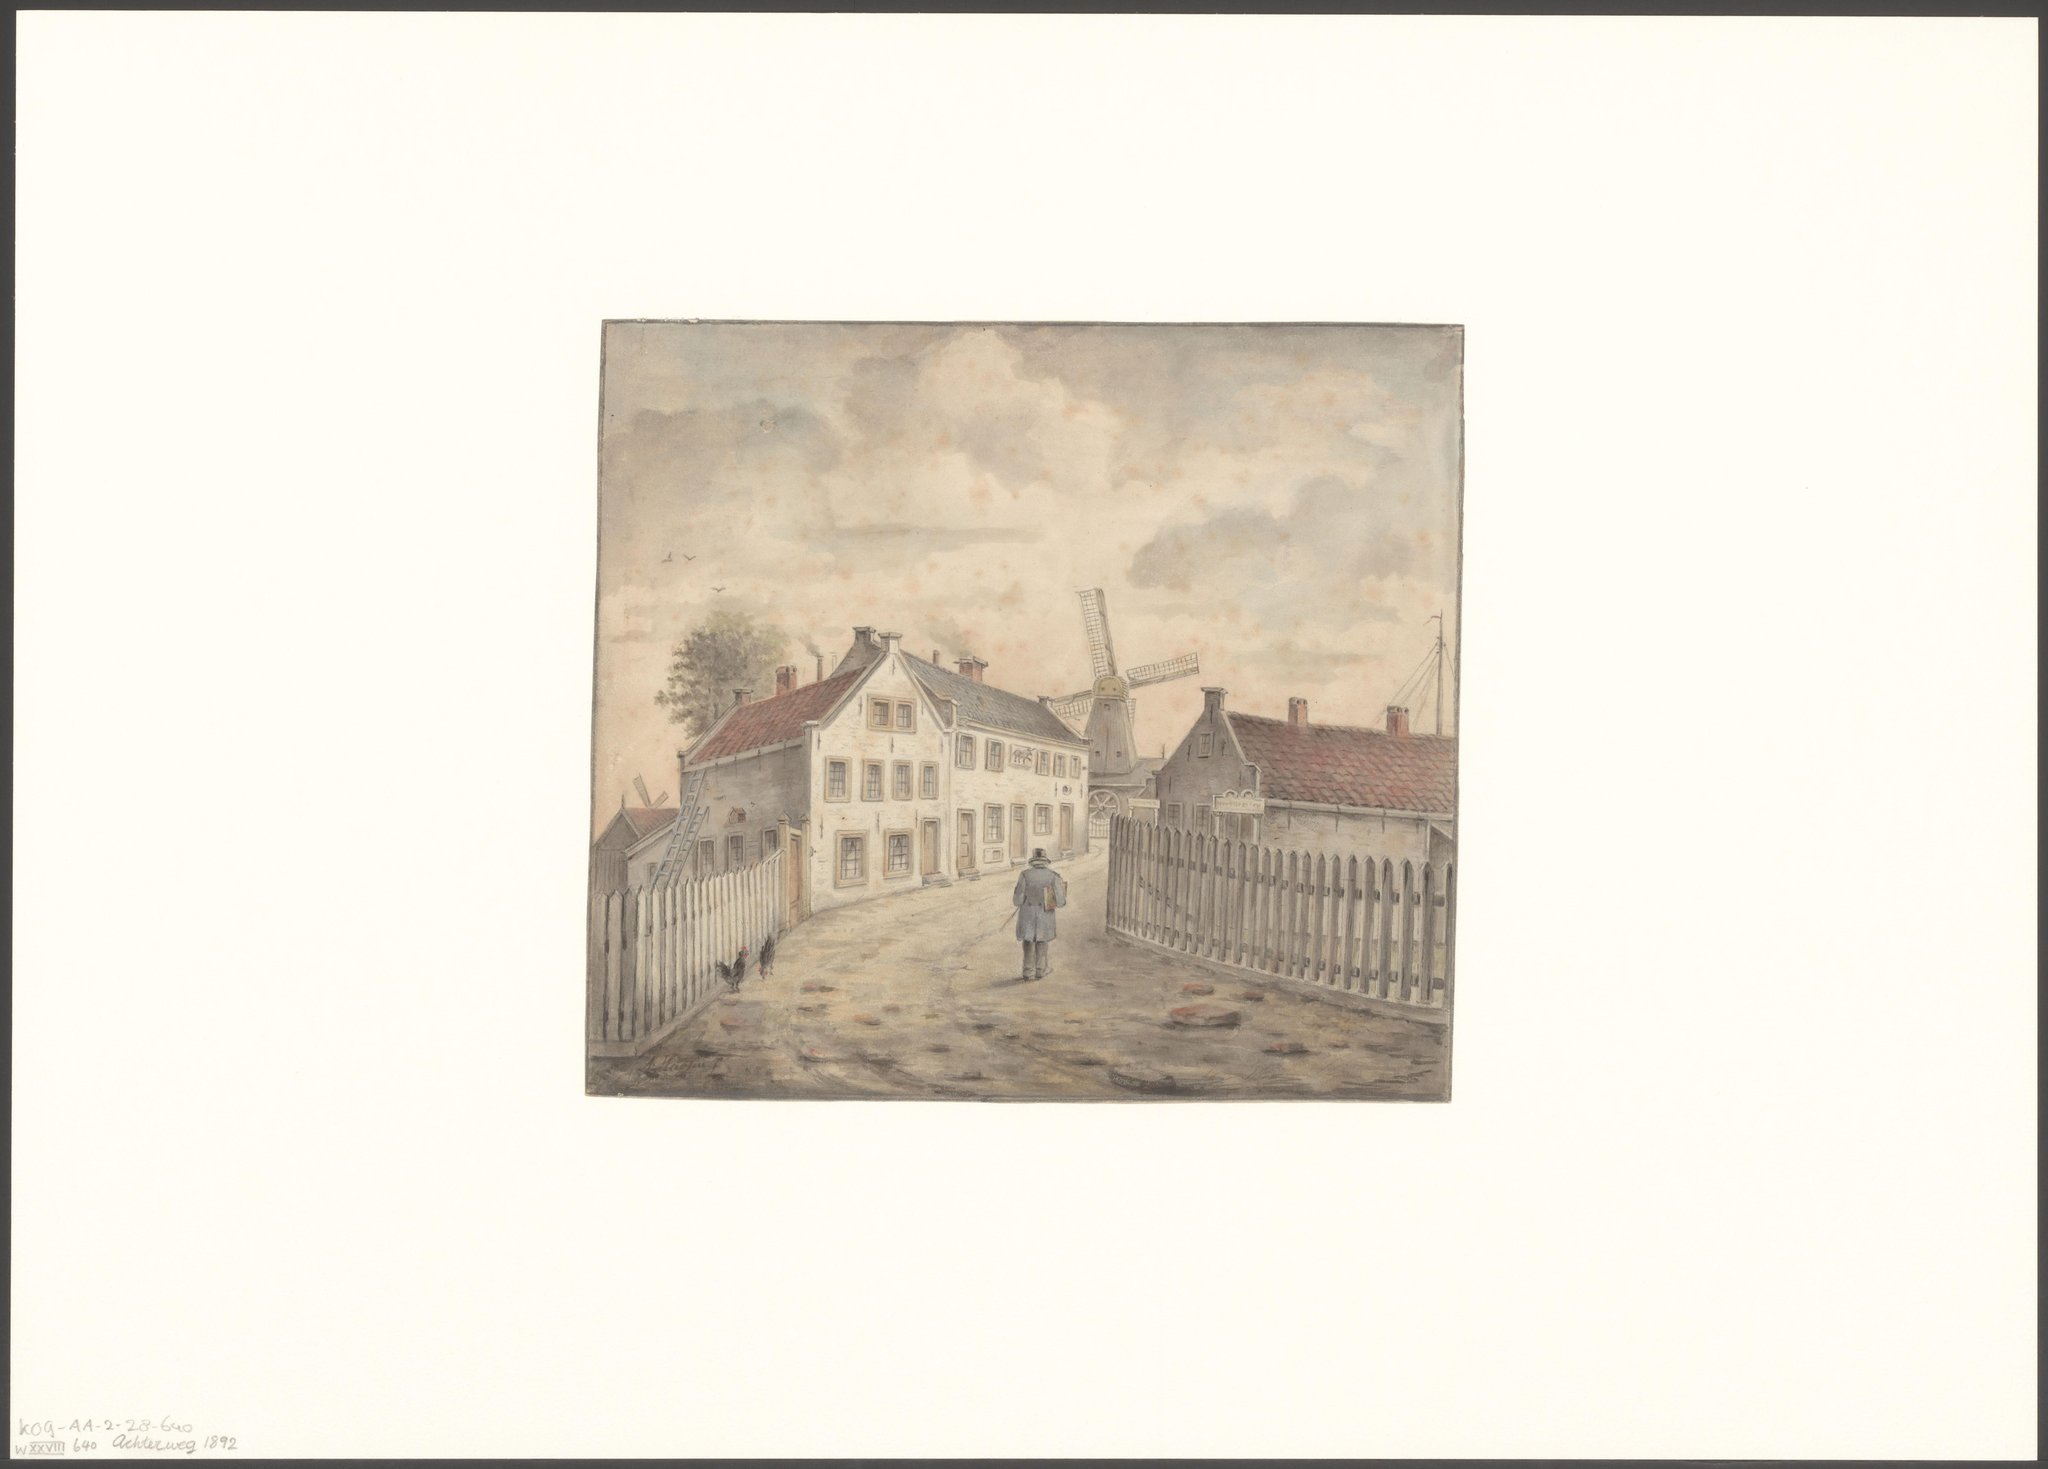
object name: drawing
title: Gezicht op molen De Eenhoorn gezien vanaf de Achterweg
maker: albert martin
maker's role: draughtsman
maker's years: 1827-1900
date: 1801-1892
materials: paper, pencil, watercolor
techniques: brush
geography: amsterdam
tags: city-view in general; 'veduta', road, path, windmill in landscape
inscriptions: collector's mark: Lugt 800a, inscription: ‘Gezicht op den Achterweg. / op de Molen de Eenhoorn Jan 1892.’, signature: ‘A:Martin f’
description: Tekening binnen de Atlas Van Eck ingedeeld op wijknummer 28.